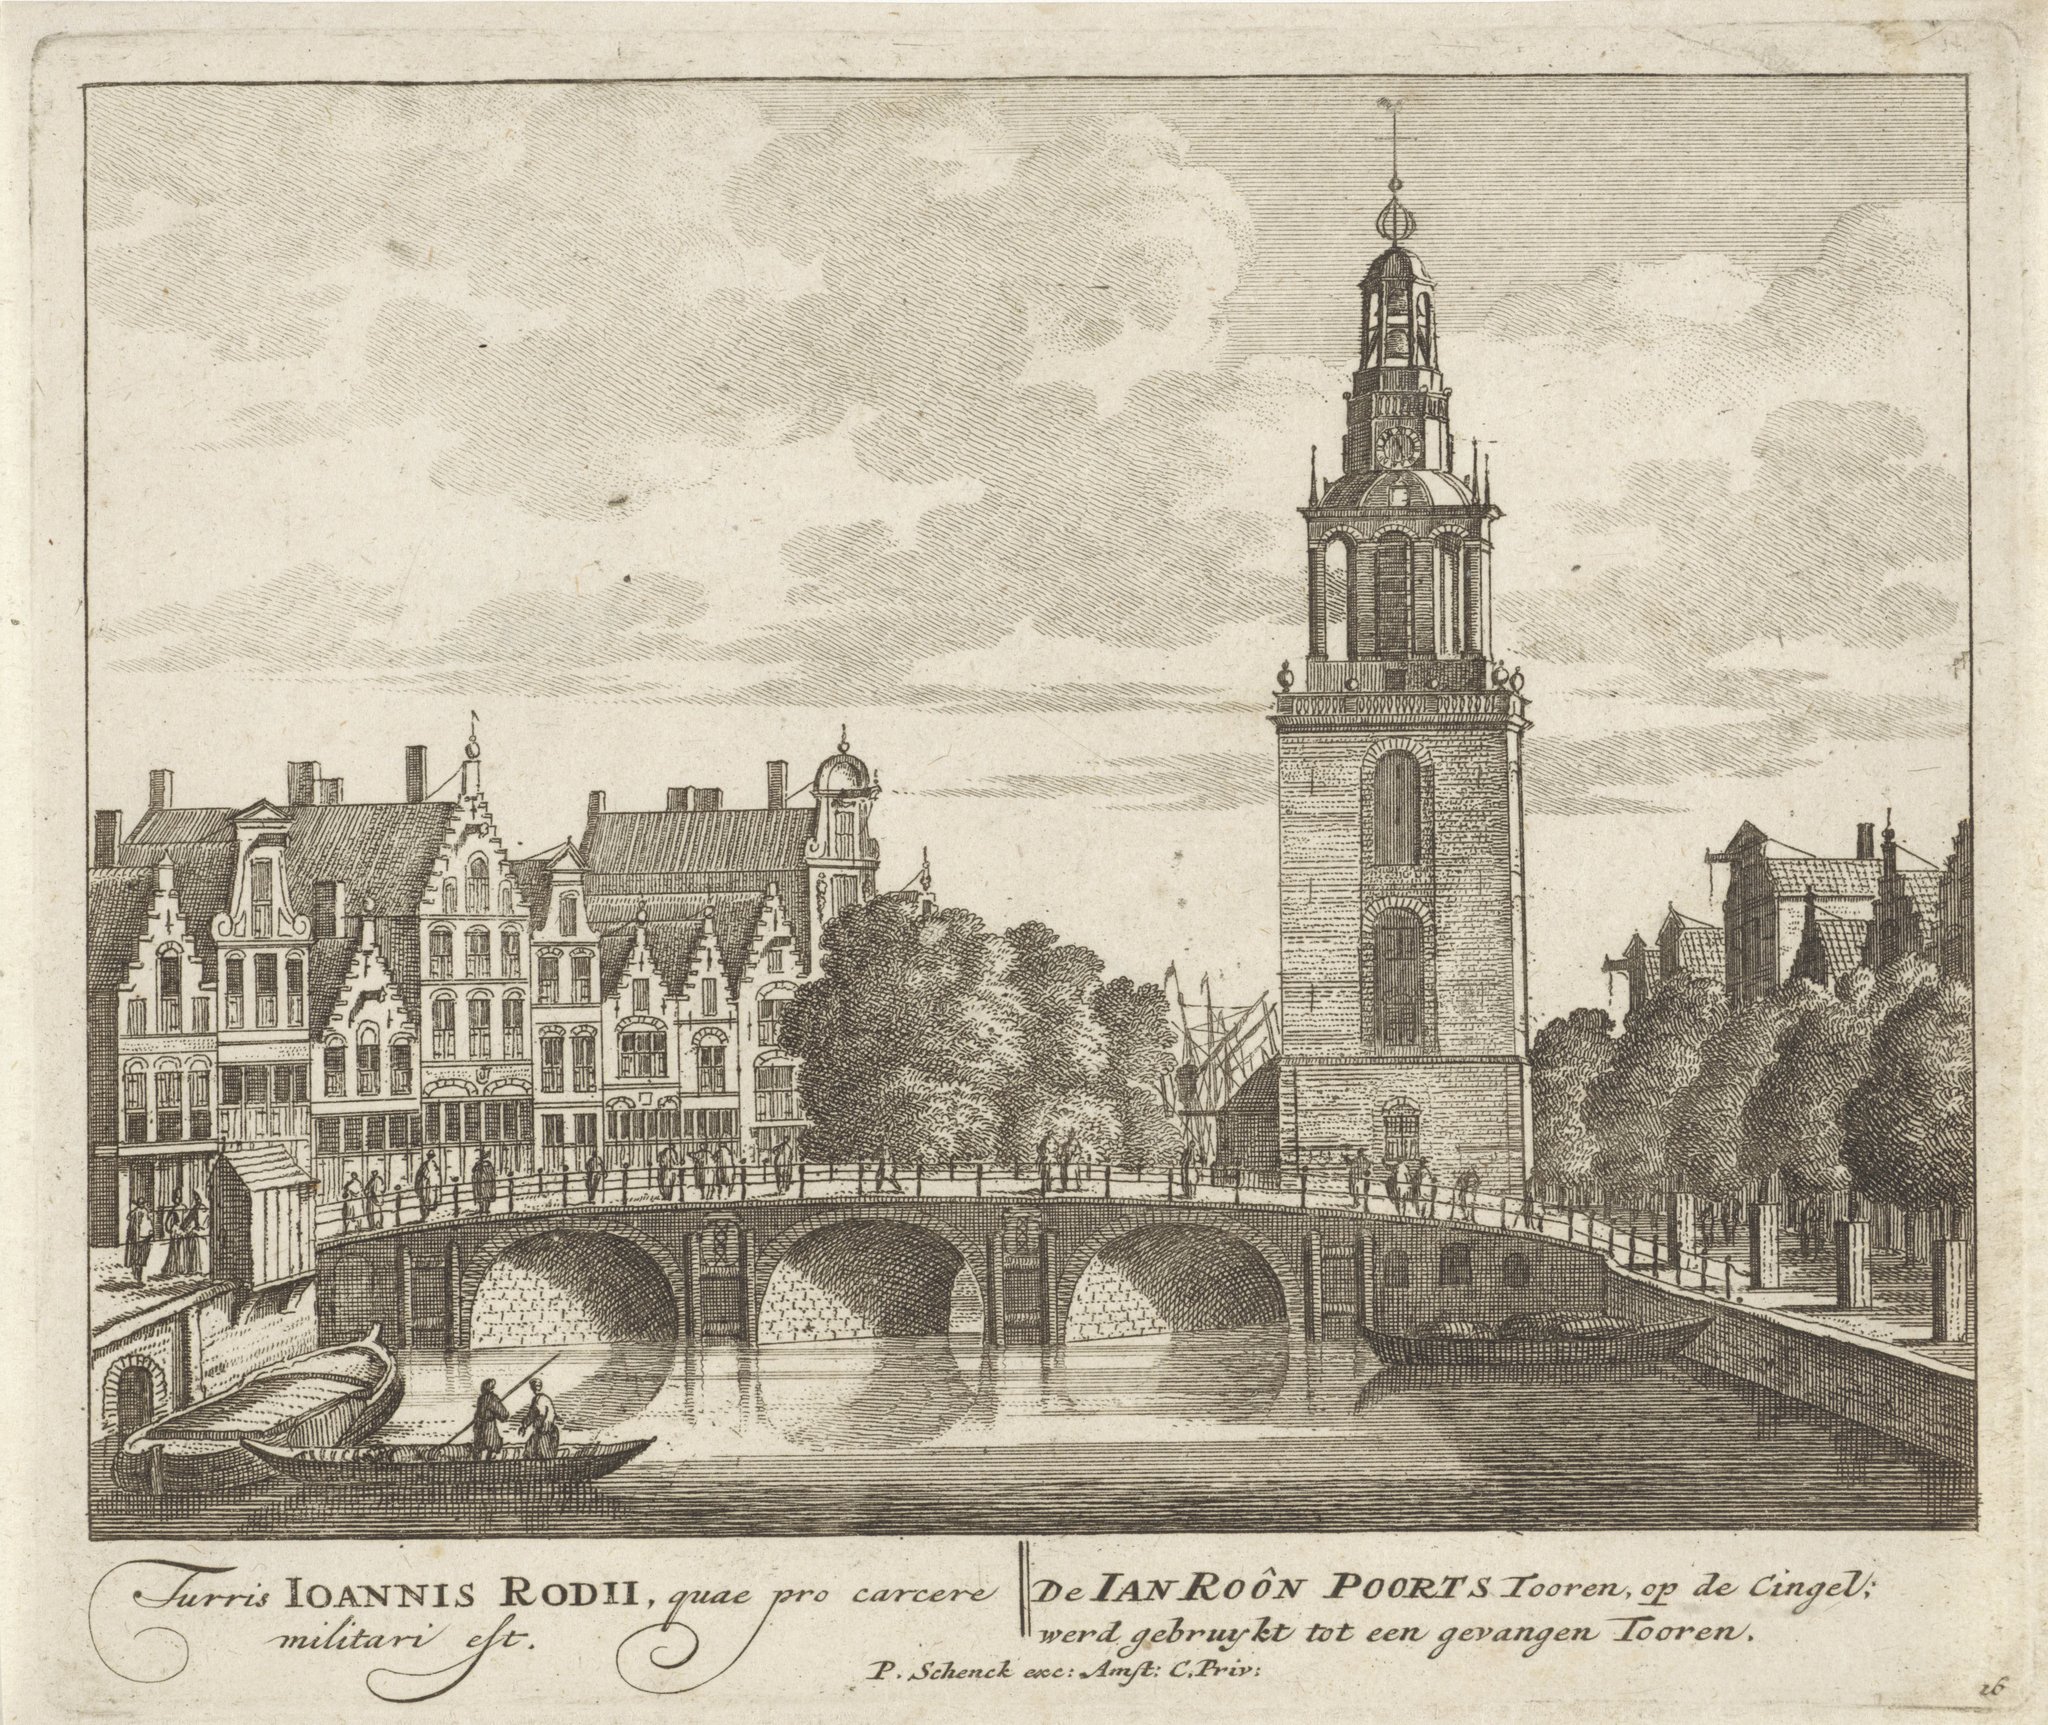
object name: print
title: 100 Afbeeldinge der voornaamste gebouwen van Amsterdam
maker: Anonymous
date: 1710-1711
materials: paper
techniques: engraving, etching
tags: bridge in city across river, canal, etc. (+ city(-scape) with figures, staffage), tower, clock tower ~ monumental adornment, street (+ city(-scape) with figures, staffage)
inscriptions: collector's mark: Lugt 2228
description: Huidige staat van prent ook gebruikt in: 100 Afbeeldinge der voornaamste gebouwen van Amsterdam. Amsterdam, Pieter Schenk (I), s.a. [1710-1711]. En in: 100 Afbeeldinge der voornaamste gebouwen van Amsterdam. Amsterdam, Barent Greve, s.a. [1757-1766].* *In de tweede uitgave, uitgegeven door Barent Greve, is alleen de titelprent aangepast. De overige prenten zijn onveranderd gebleven.